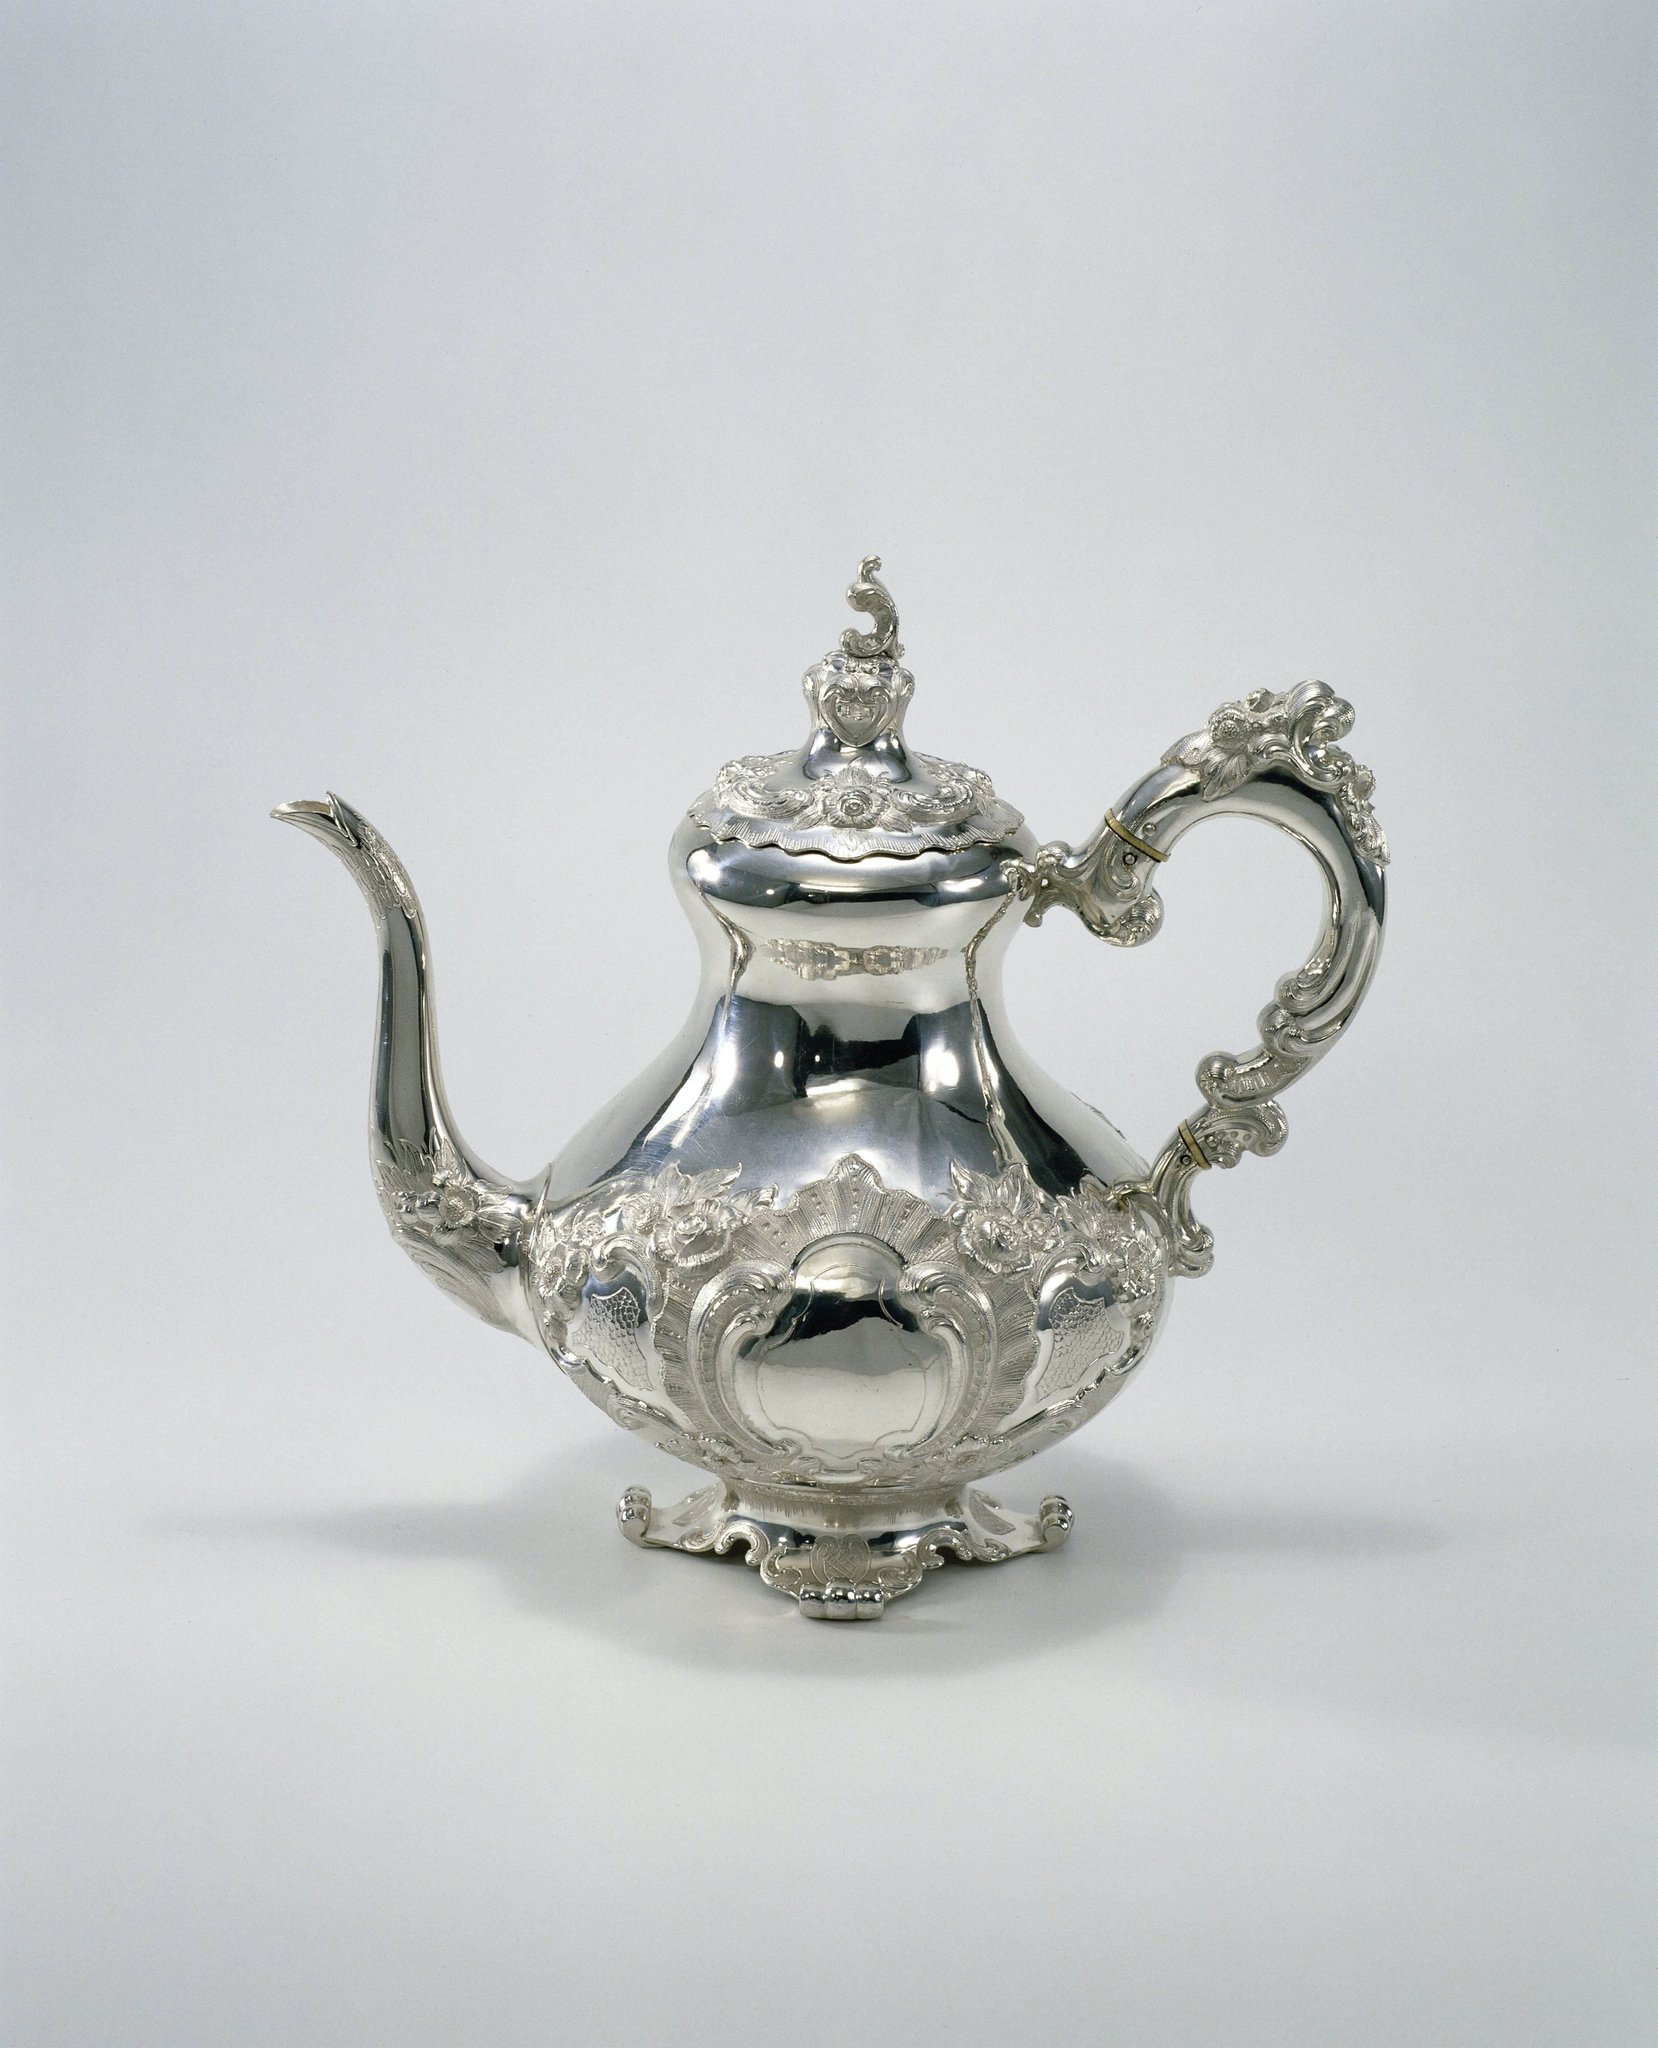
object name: coffee pot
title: Koffiepot, peervormig, met rocailles en C- en S-voluten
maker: daniel jan de haas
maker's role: silversmith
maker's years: 1821-1886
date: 1863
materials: ivory, silver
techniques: engraving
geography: amsterdam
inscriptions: alloy mark, assay office mark, maker's mark, retailer's mark: ‘A.D. VERSCHUUR’, date letter: ‘D’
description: Coffee pot and four-piece tea service. Silver and ivory. Amsterdam, 1863, 1865, by Daniel Jan de Haas, designed by A.D. Verschuur.